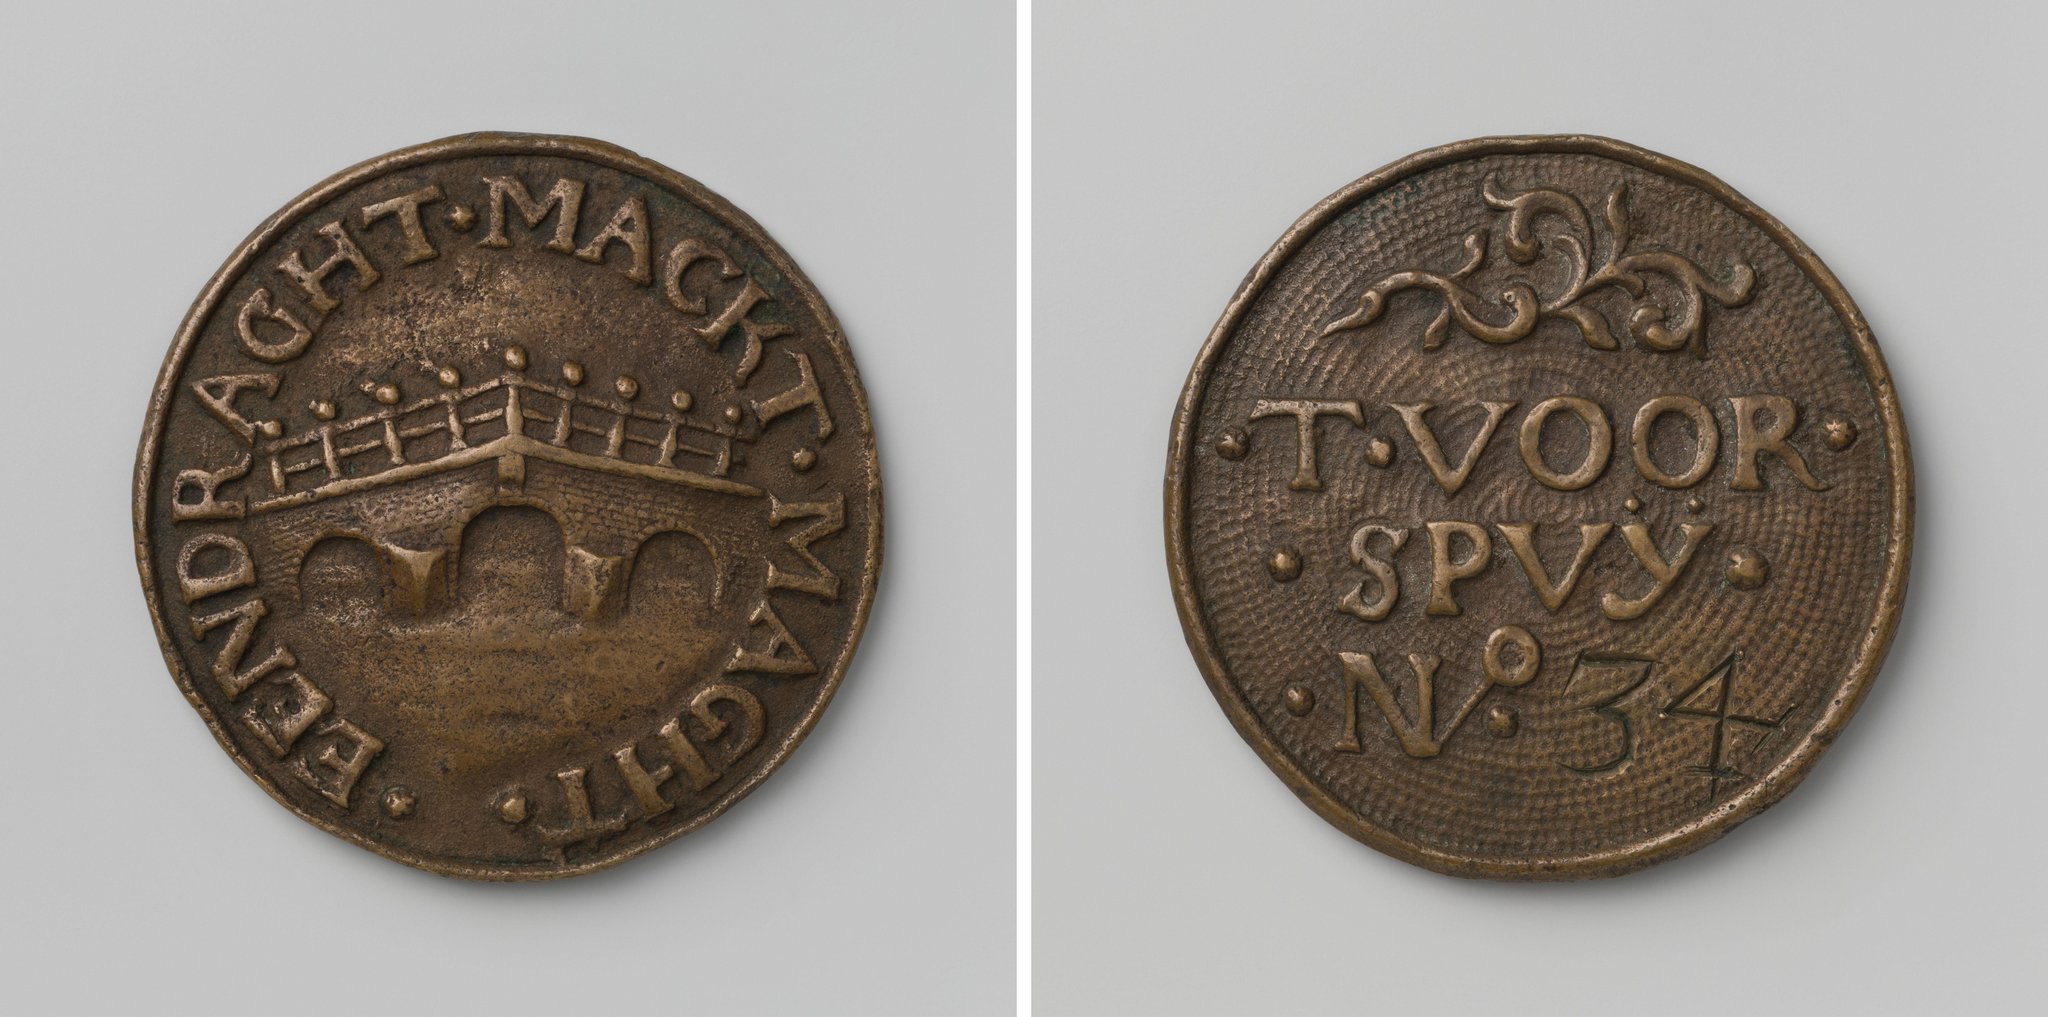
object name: buurtpenning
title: Buurt van het Voorspui te 's-Gravenhage, buurtpenning met no. 34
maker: Anonymous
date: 1600-1750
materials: brass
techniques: casting, engraving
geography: the hague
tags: voorspui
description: Messing penning. Voorzijde: brug binnen omschrift. Keerzijde: bladertakje boven opschrift en cijfer no. 34